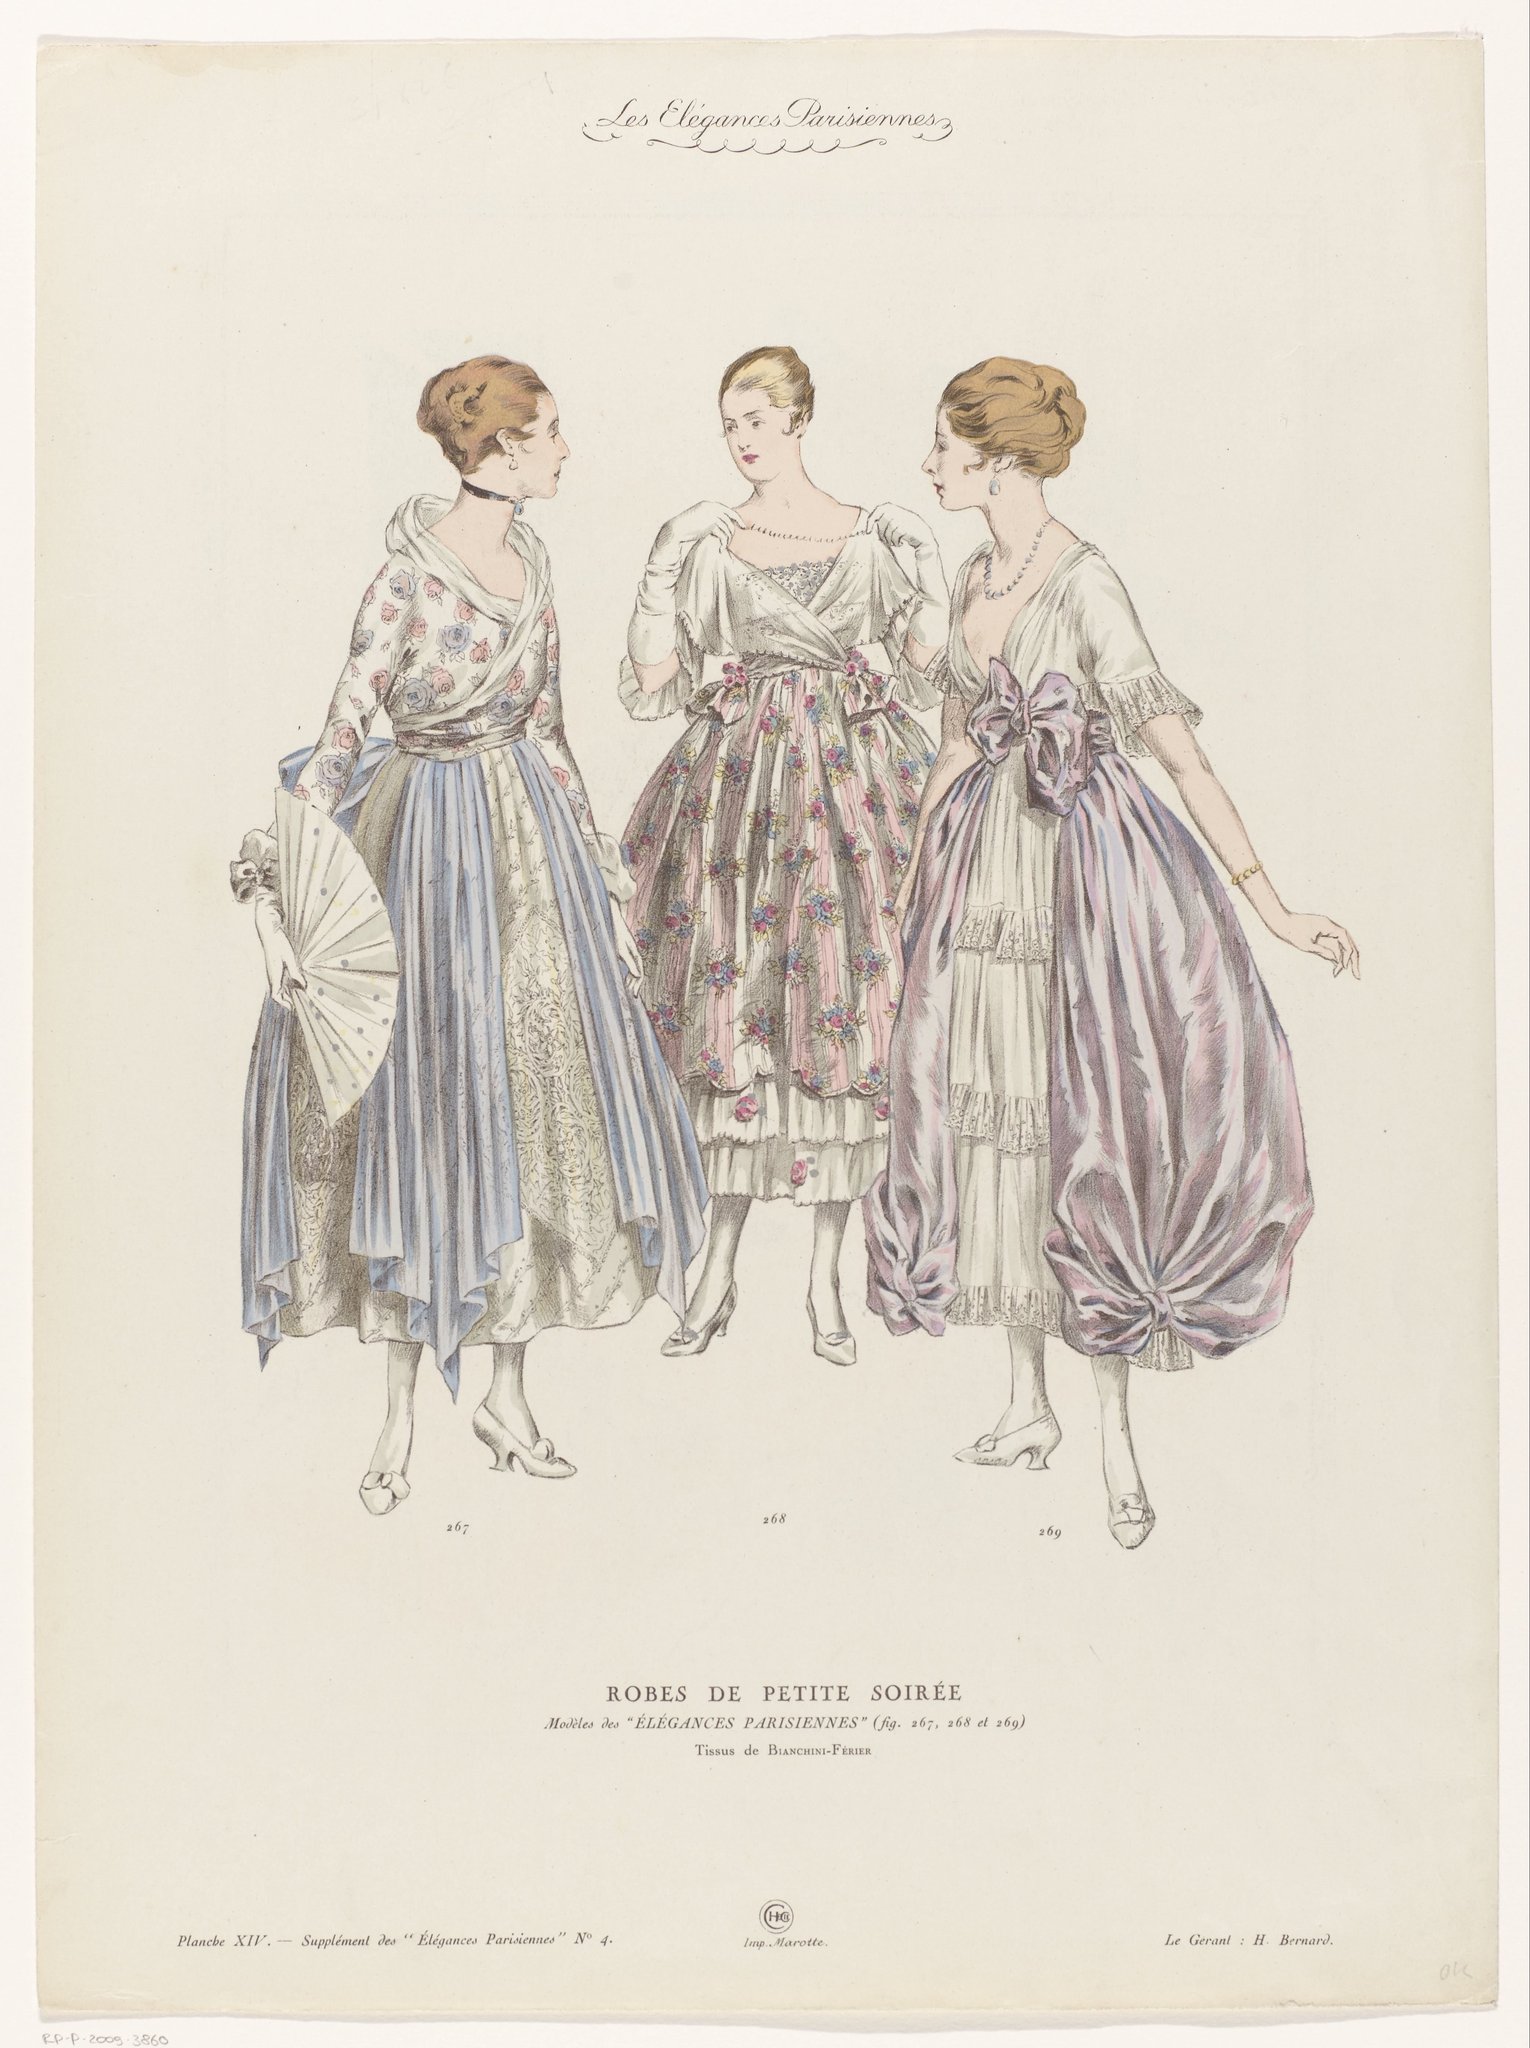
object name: fashion print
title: Les Élégances Parisiennes, ca. 1916, Supplément No 4, Pl. XIV en XV, fig. 267 t/m 274 : ROBES DE PETITE SOIRÉ (...)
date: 1916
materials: paper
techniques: hand coloring, lithograph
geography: paris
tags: bow (ornamental part of clothing) (+ women's clothes), dress, gown: evening dress (+ women's clothes), gloves, mittens (long gloves) (+ women's clothes), veil (+ women's clothes), head-gear: boater (+ women's clothes), fashion plates, head-gear: hat (+ women's clothes), shoes, sandals (+ women's clothes), fan (+ women's clothes), necklace (+ women's clothes)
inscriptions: title: ‘Les Elégances Parisiennes’, title: ‘Les Elégances Parisiennes’, caption: ‘ROBES DE PETITE SOIRÉE / Modèles des "ÉLÉGANCES PARISIENNES" (fig. 267, 268 et 269) / Tissus de BIANCHINI-FÉRIER’, inscription: ‘Planche XV. - Supplément des "Élégances Parisiennes" No 4. / Le Gerant: H. Bernard.’, inscription: ‘Planche XIV. - Supplément des "Élégances Parisiennes" No 4. / Le Gerant: H. Bernard.’, caption: ‘CHAPEAUX / Modèles de GEORGETTE (fig. 270, 271, 272, 273 et 274)’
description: Recto: Drie vrouwen gekleed in avondjaponnen voor een 'petite soirée', genummerd 267, 268 en 269. Volgens het onderschrift: 'modèles des Élégances Parisiennes'. Stoffen van Bianchini-Férier. Verso: Vijf vrouwenhoofden met verschillende hoeden, genummerd 270 t/m 274. Volgens het onderschrift: 'modèles' van Georgette. Prent uit het modetijdschrift Les Élégances Parisiennes (1916-1924).